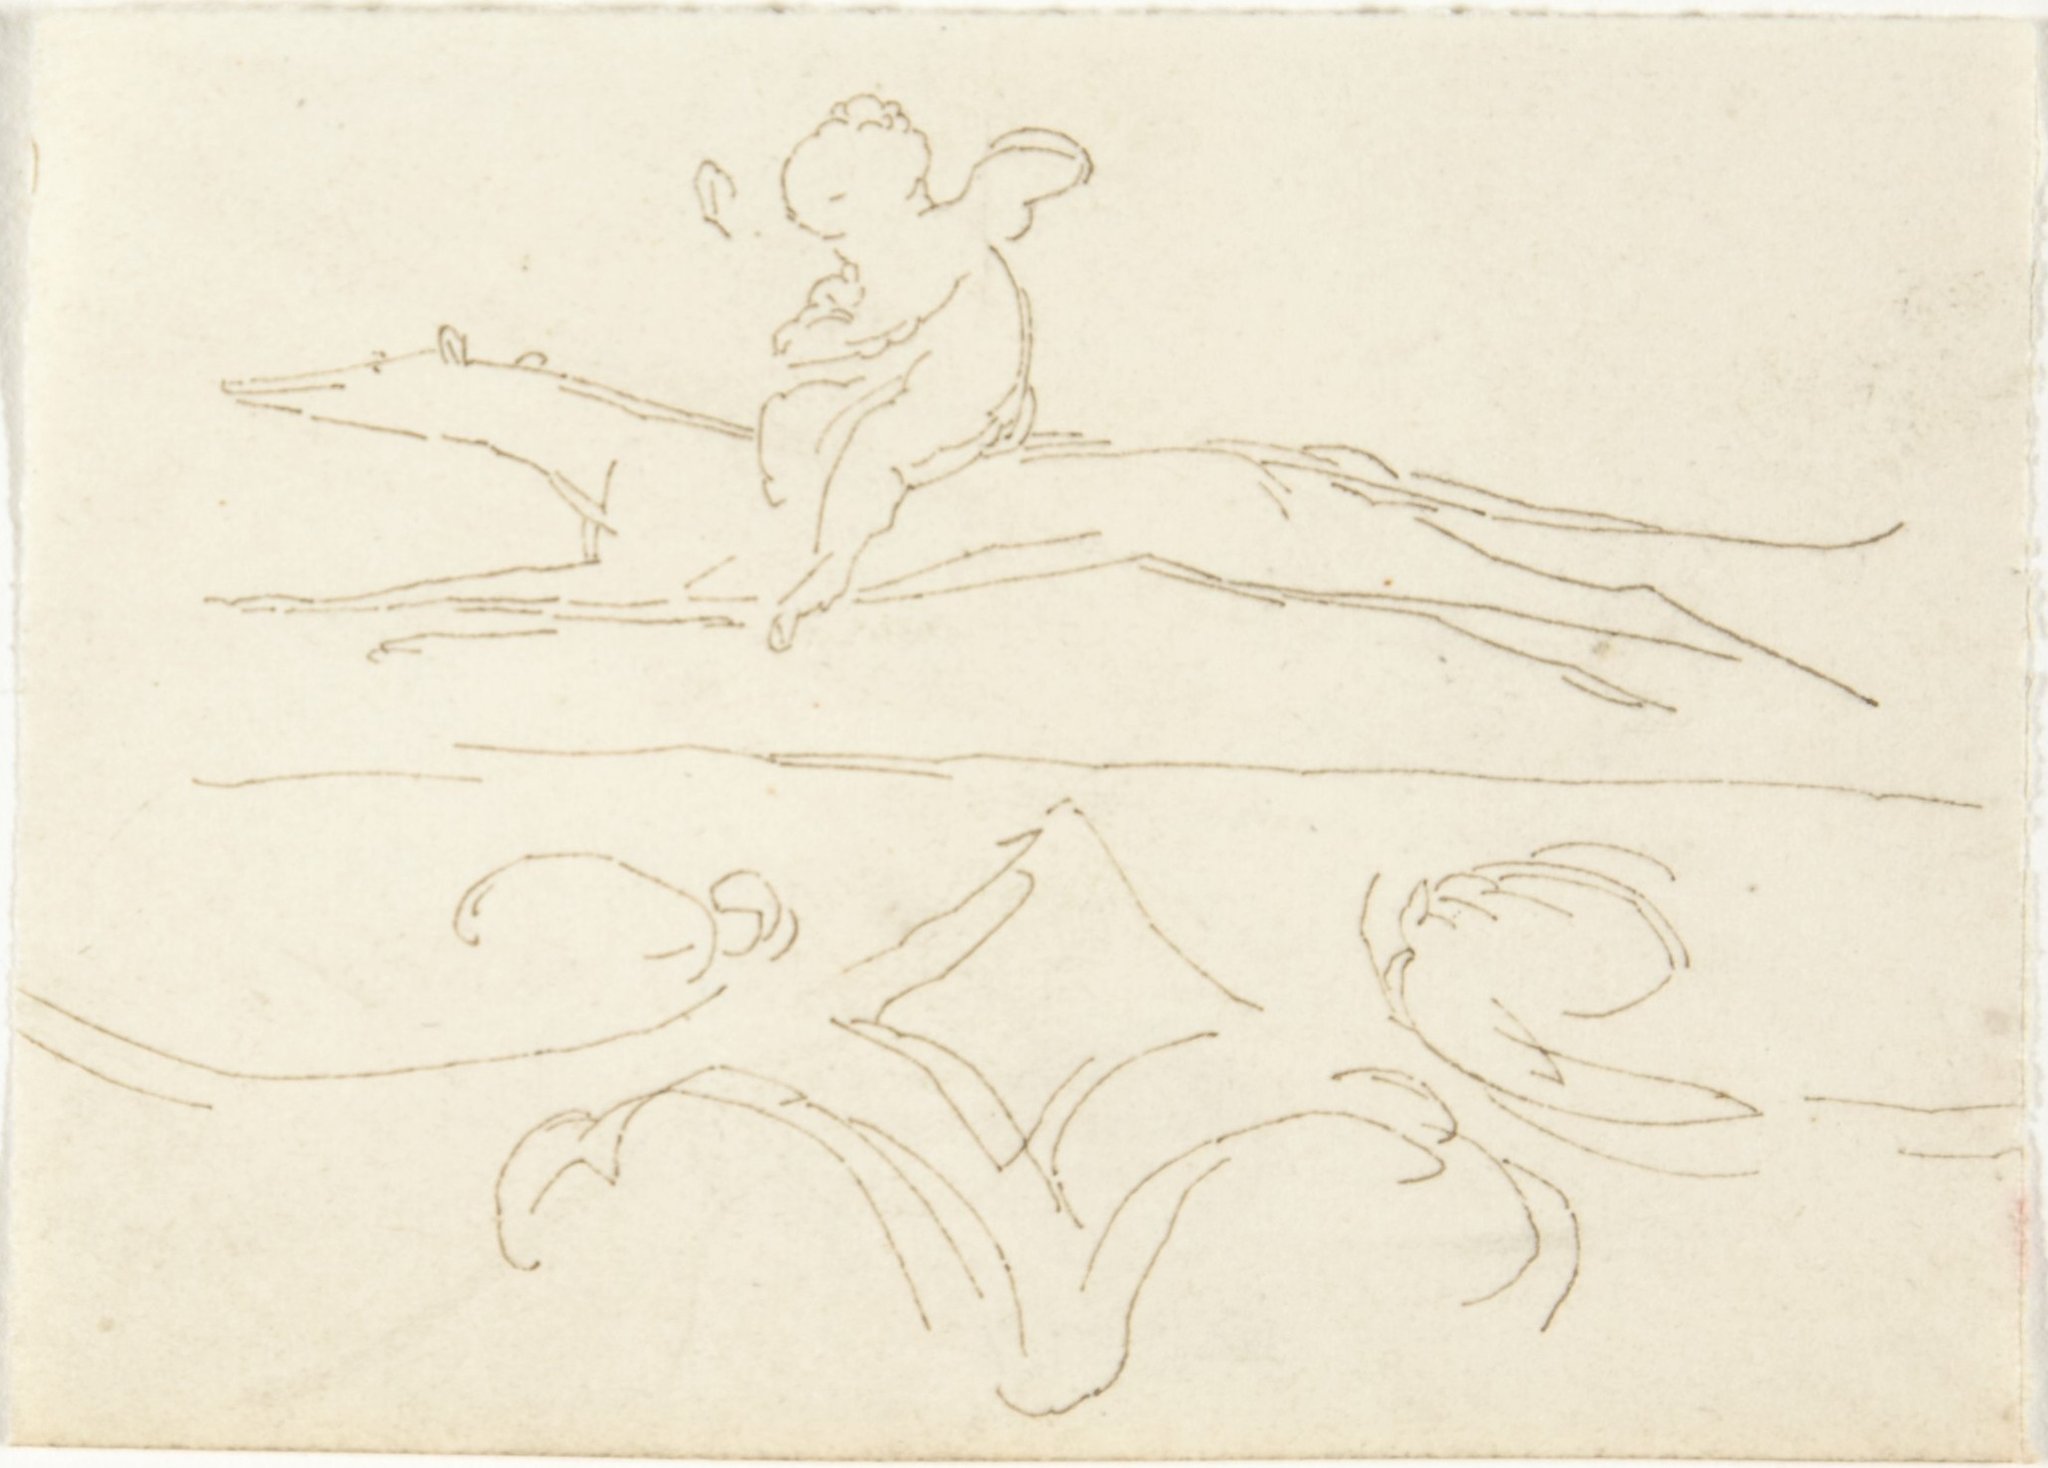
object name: drawing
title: Sketch of a Child Riding a Dog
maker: william pitts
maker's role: artist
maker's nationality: british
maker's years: 1790-1840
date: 1805-1840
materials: ink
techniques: pen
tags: dogs